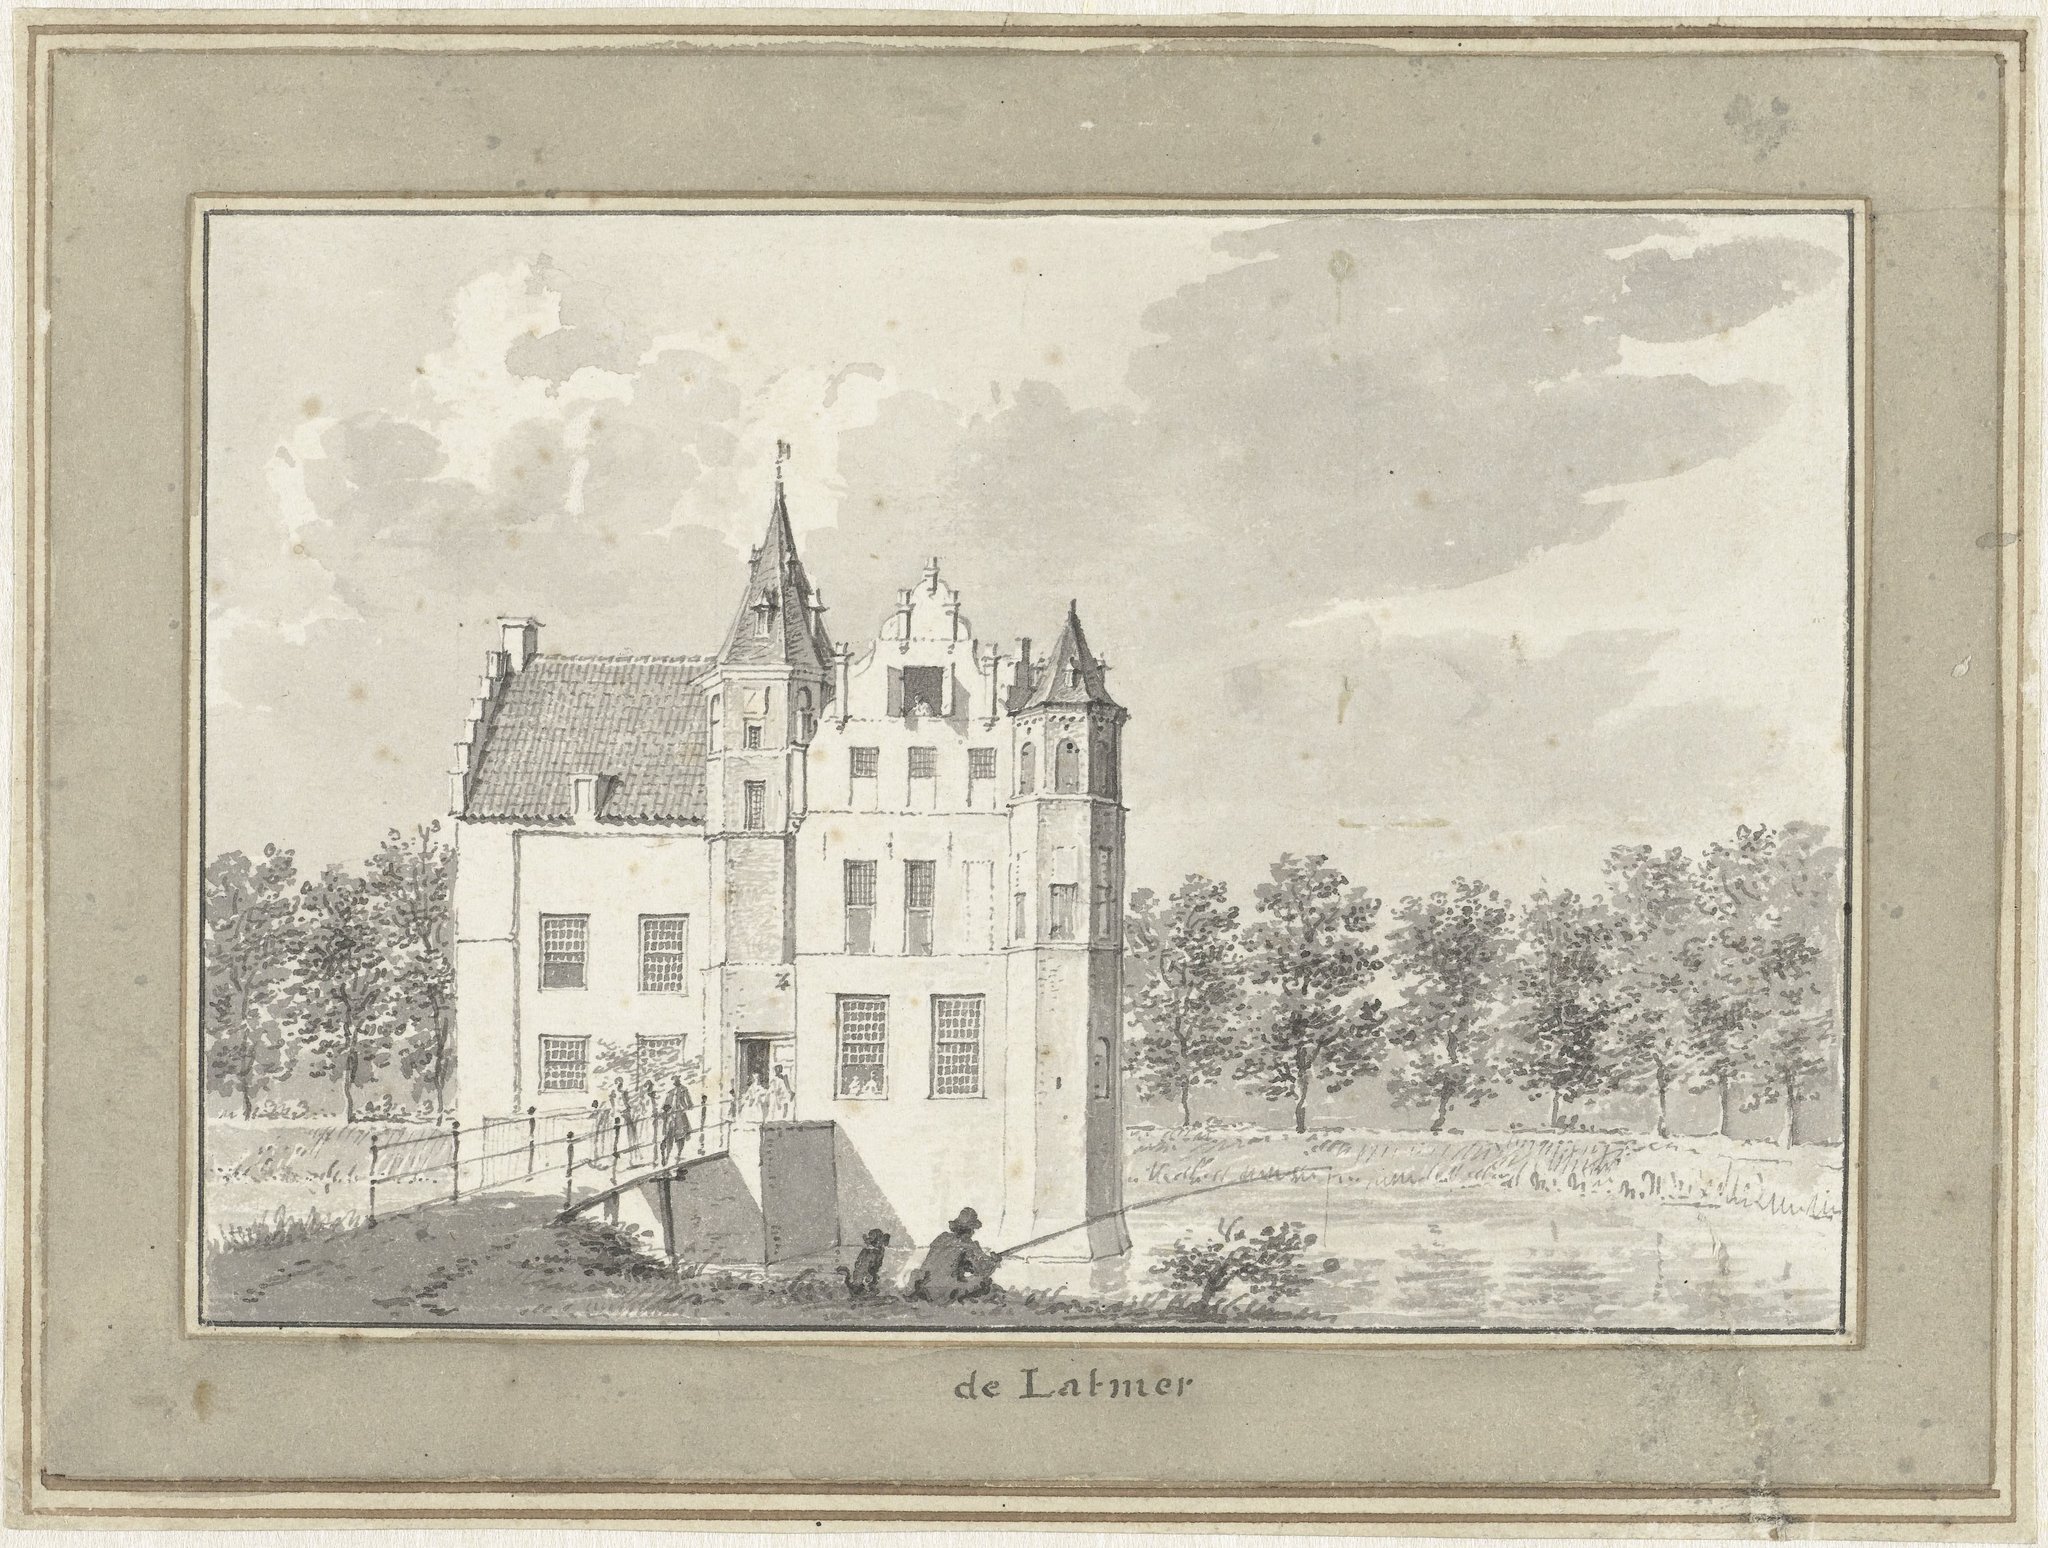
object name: drawing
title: Huis De Latmer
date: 1713-1780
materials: ink, paper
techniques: brush, pen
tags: castle